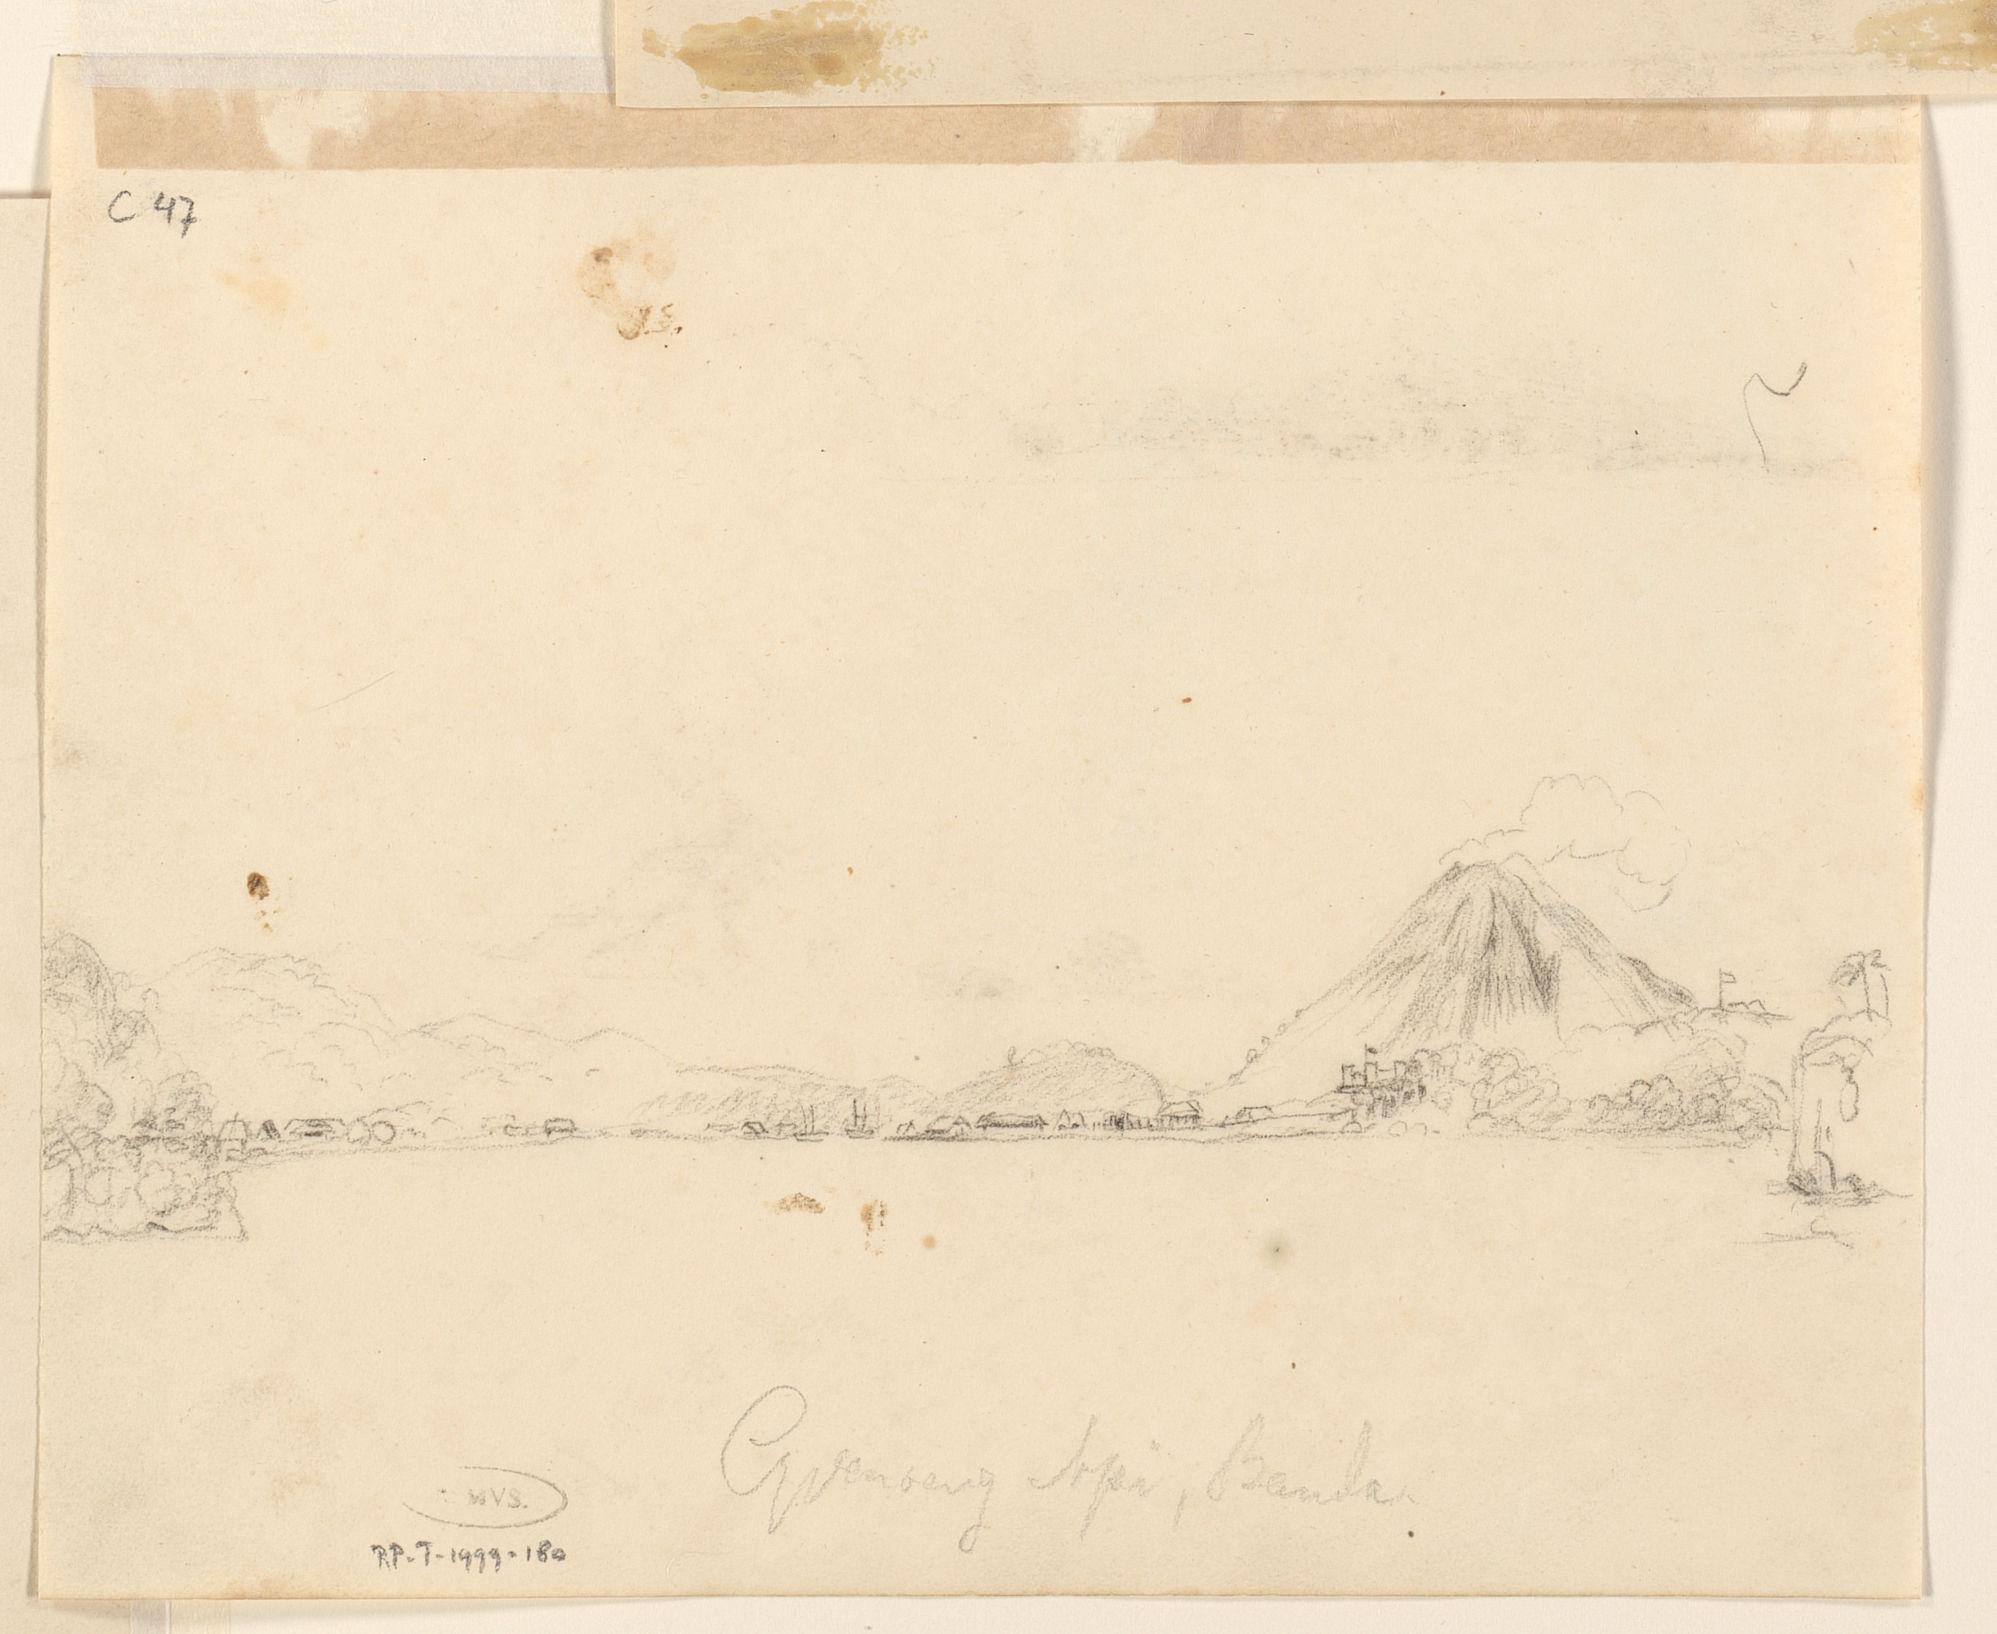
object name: topographical view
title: Gezicht op de Banda-eilanden, rechts de rokende vulkaan Gunungapi, Centraal-Molukken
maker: adrianus johannes bik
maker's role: draughtsman, print maker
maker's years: 1790-1872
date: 1824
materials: chalk, paper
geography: central moluccas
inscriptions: annotation: ‘Gunung Api, Banda’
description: artikel over deze collectie in Bulletin van het Rijksmuseum 49 [2001], nr. 4, pp.343 e.v.